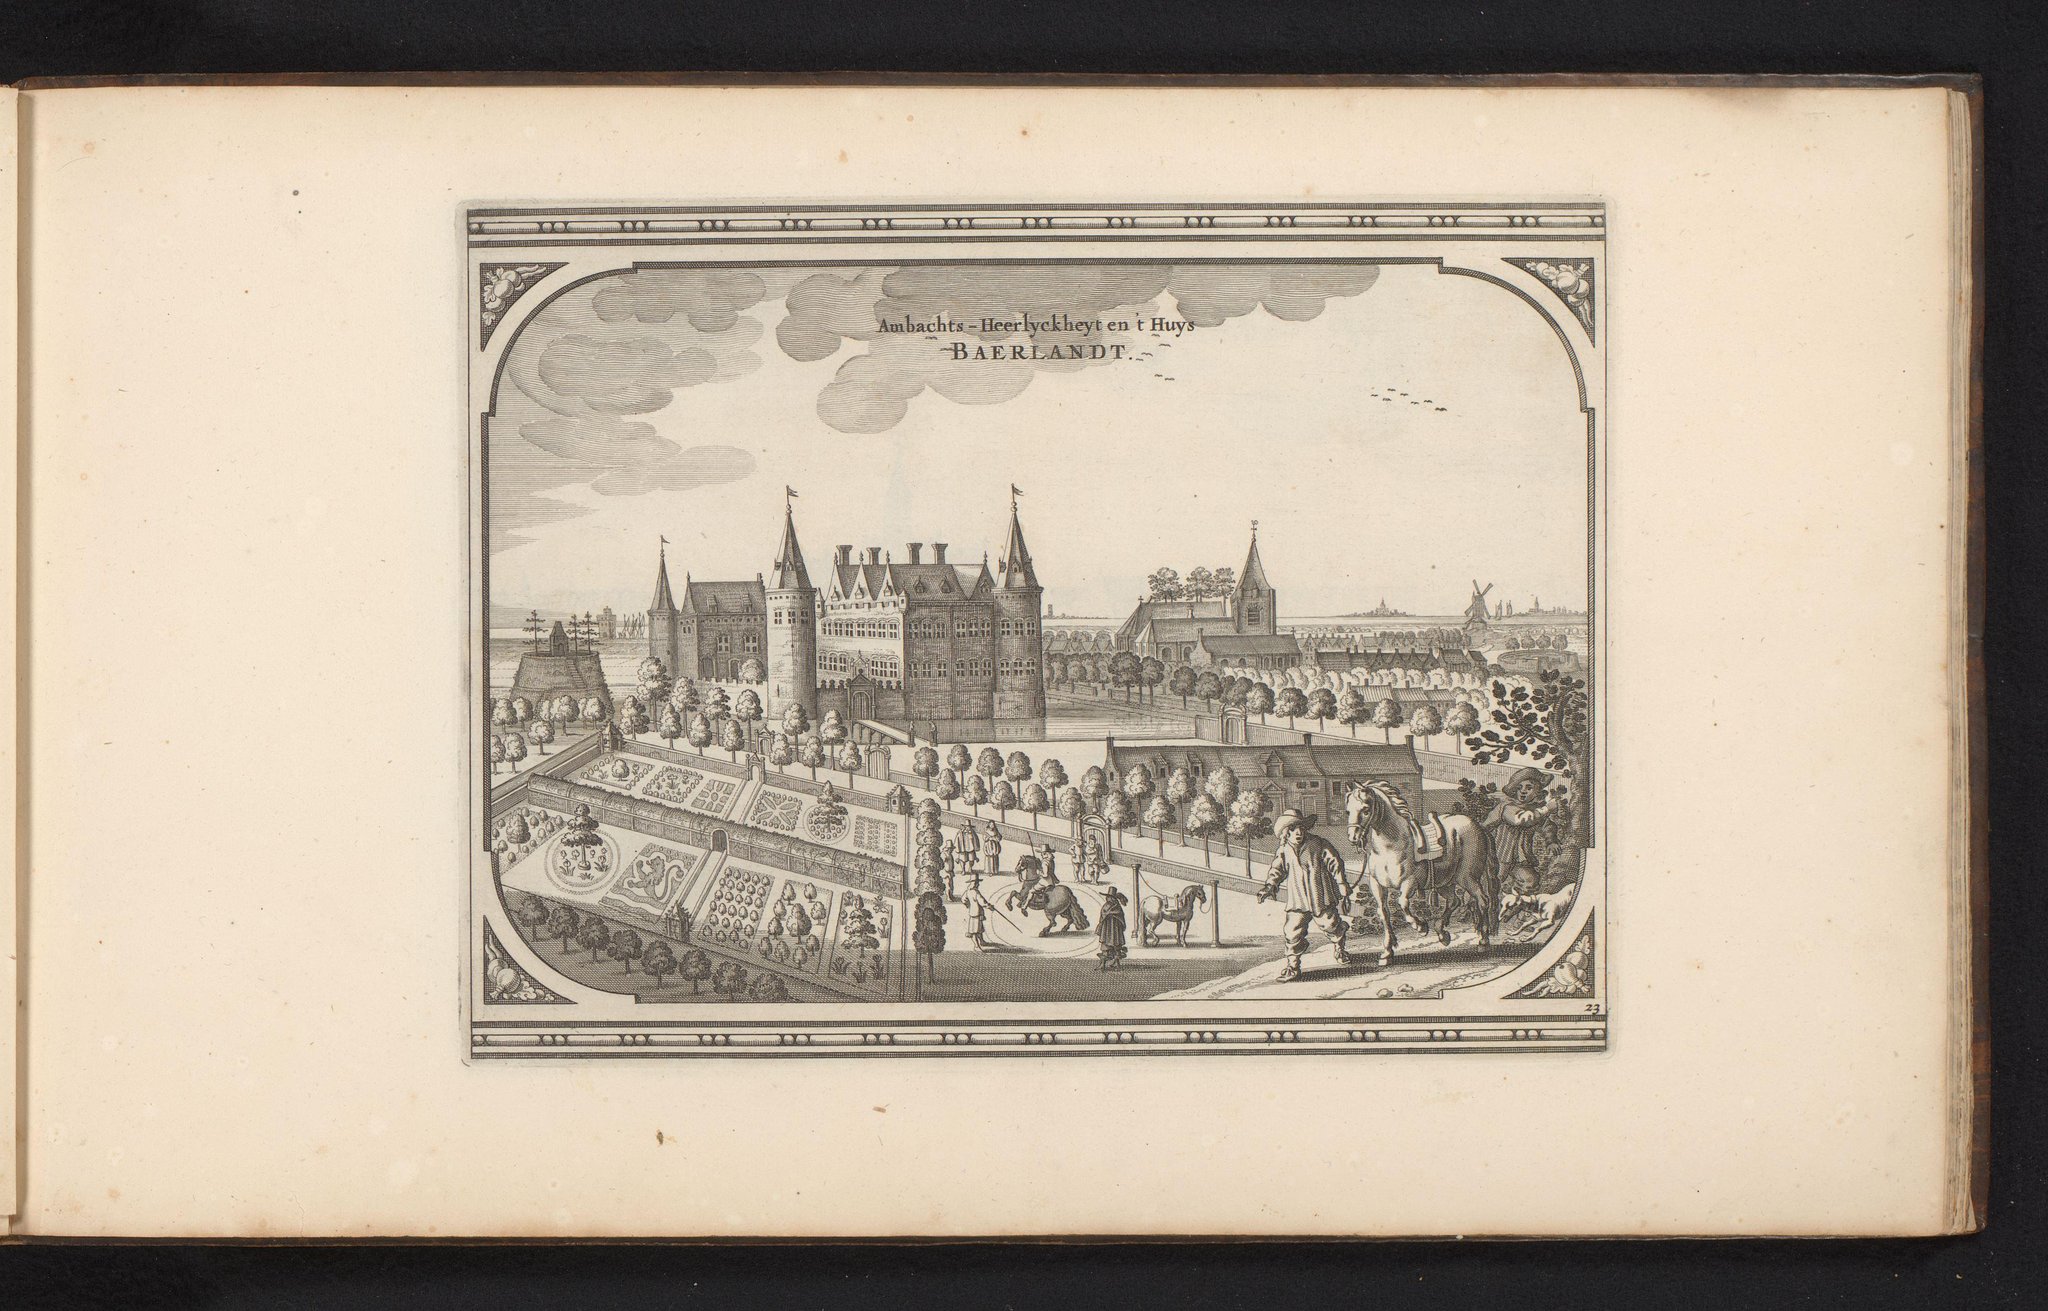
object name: album leaf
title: Ambachts-Heerlyckheyt en 't Huys Baerlandt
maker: pieter hendricksz. schut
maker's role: print maker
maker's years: 1618-1660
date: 1662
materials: paper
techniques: etching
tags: city-view, and landscape with man-made constructions, castle, garden, training of horses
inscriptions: collector's mark: Lugt 195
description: Gezicht op Slot Baarland (het Hof van Baarland) en zijn tuinen. Eén van de tuinen is aangelegd in de vorm van het wapen van Zeeland. Op de voorgrond worden paarden getraind. De prent maakt deel uit van een album.